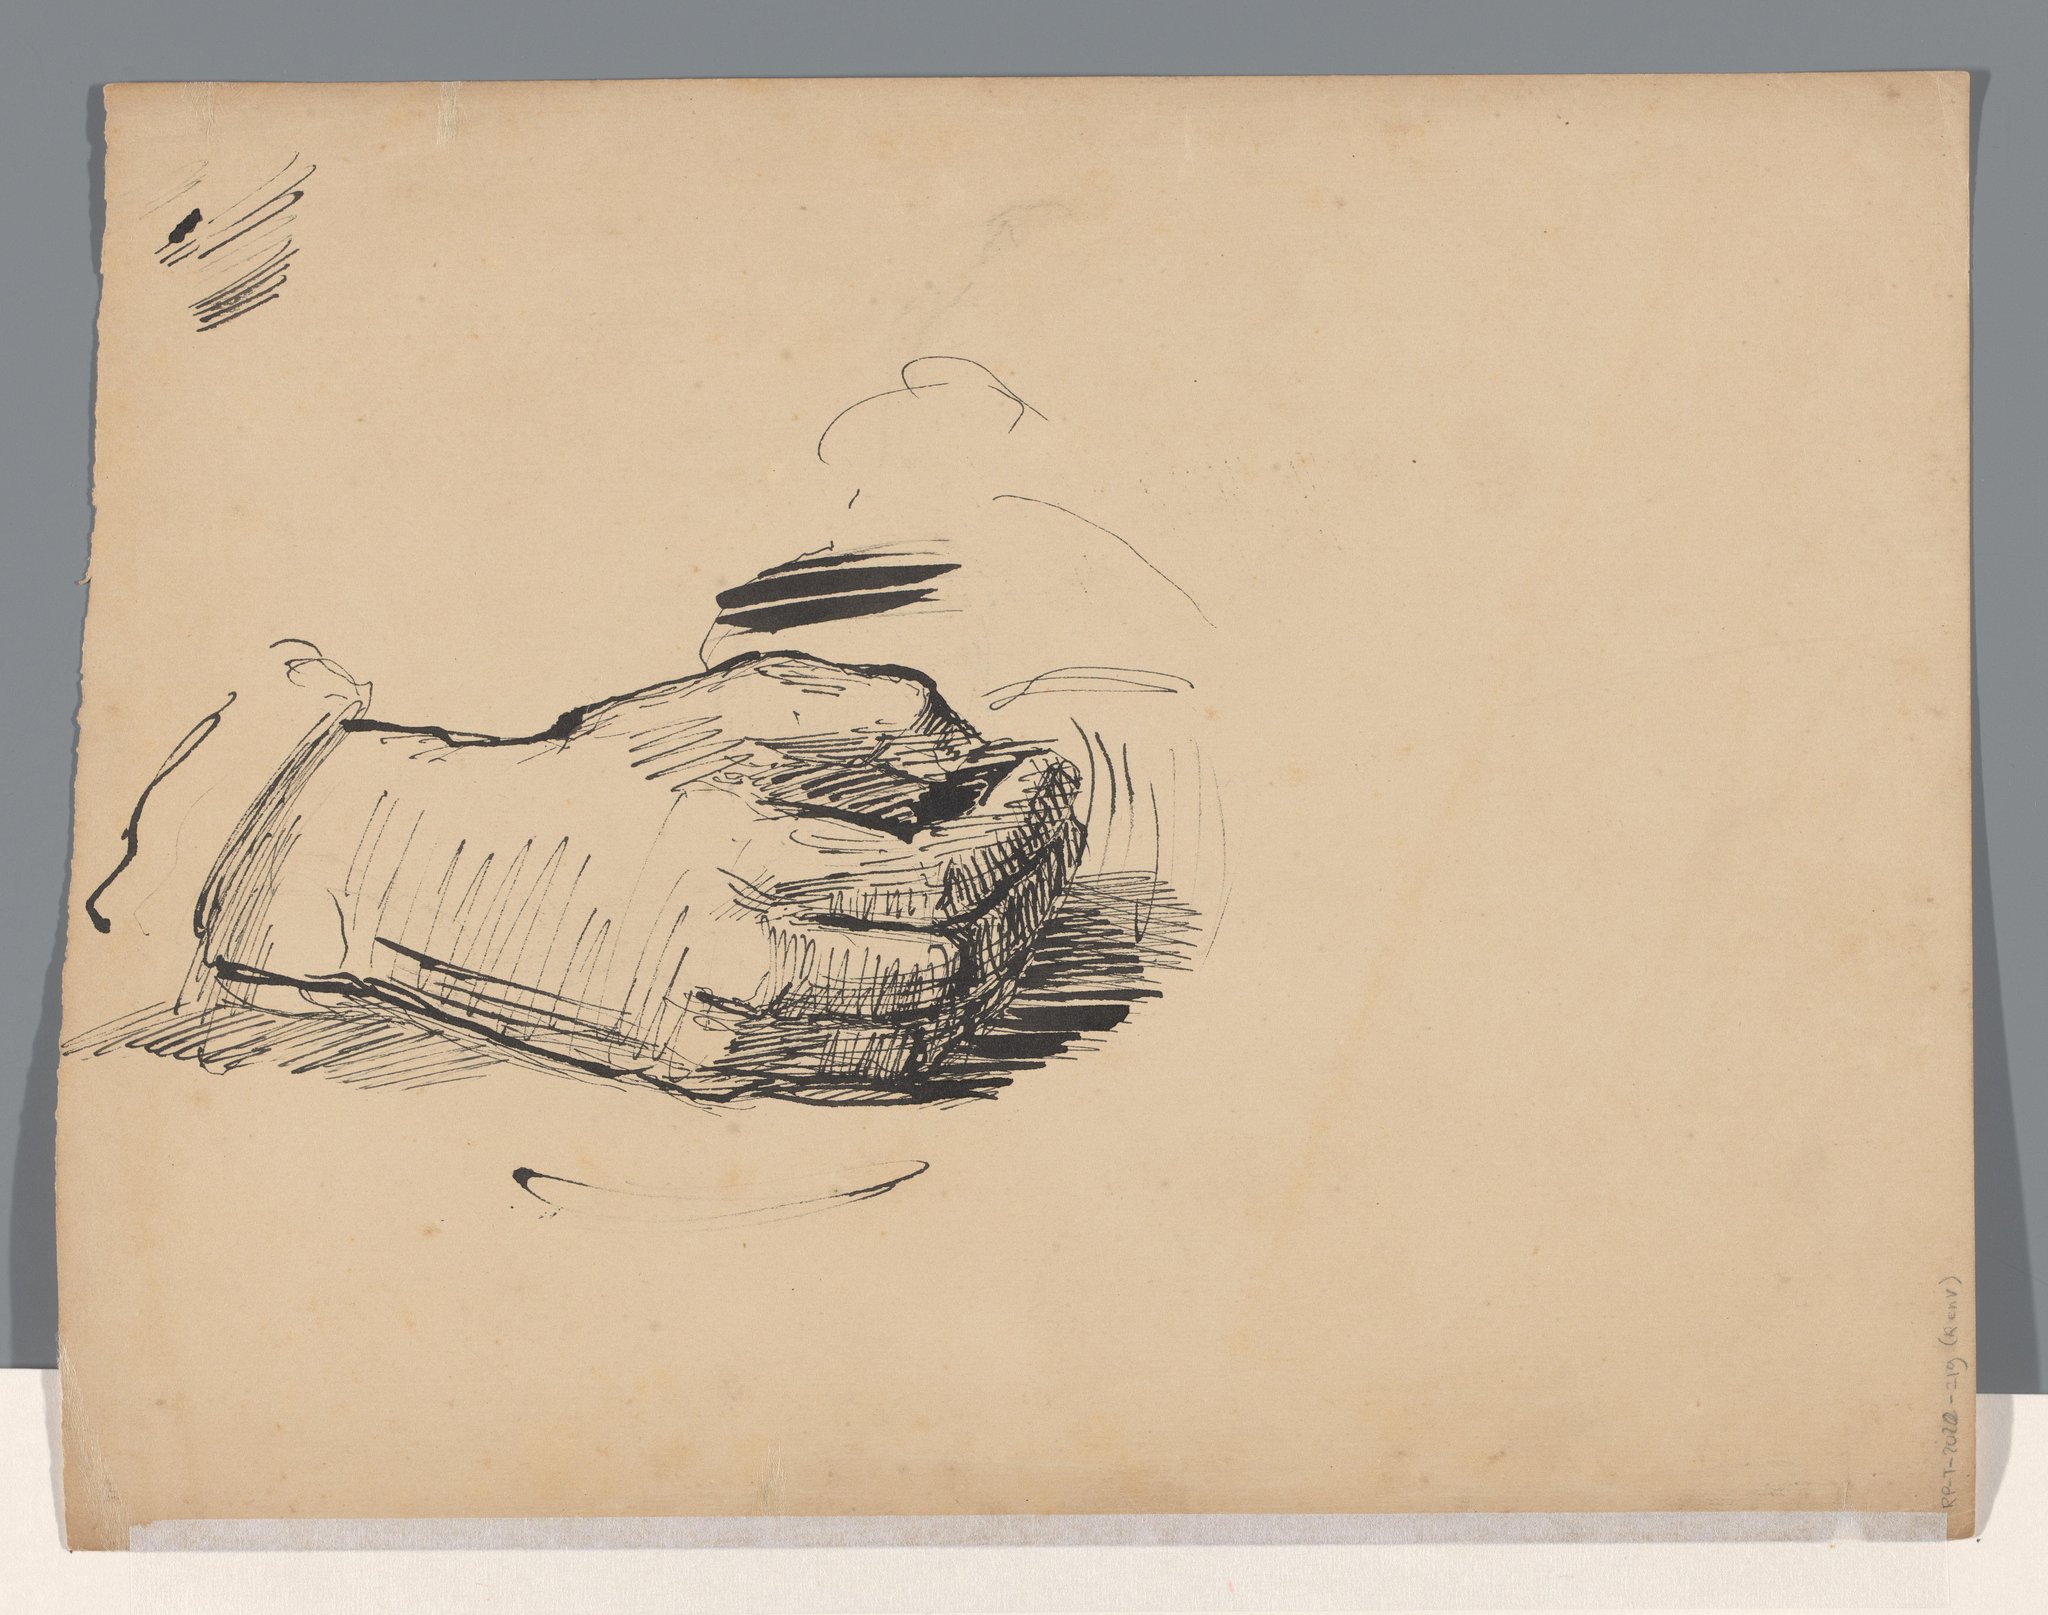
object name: schetsblad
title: Hand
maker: johanna behrend-croiset van der kop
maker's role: draughtsman, painter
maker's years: 1861-1943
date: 1880-1900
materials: ink, paper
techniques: pen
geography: netherlands